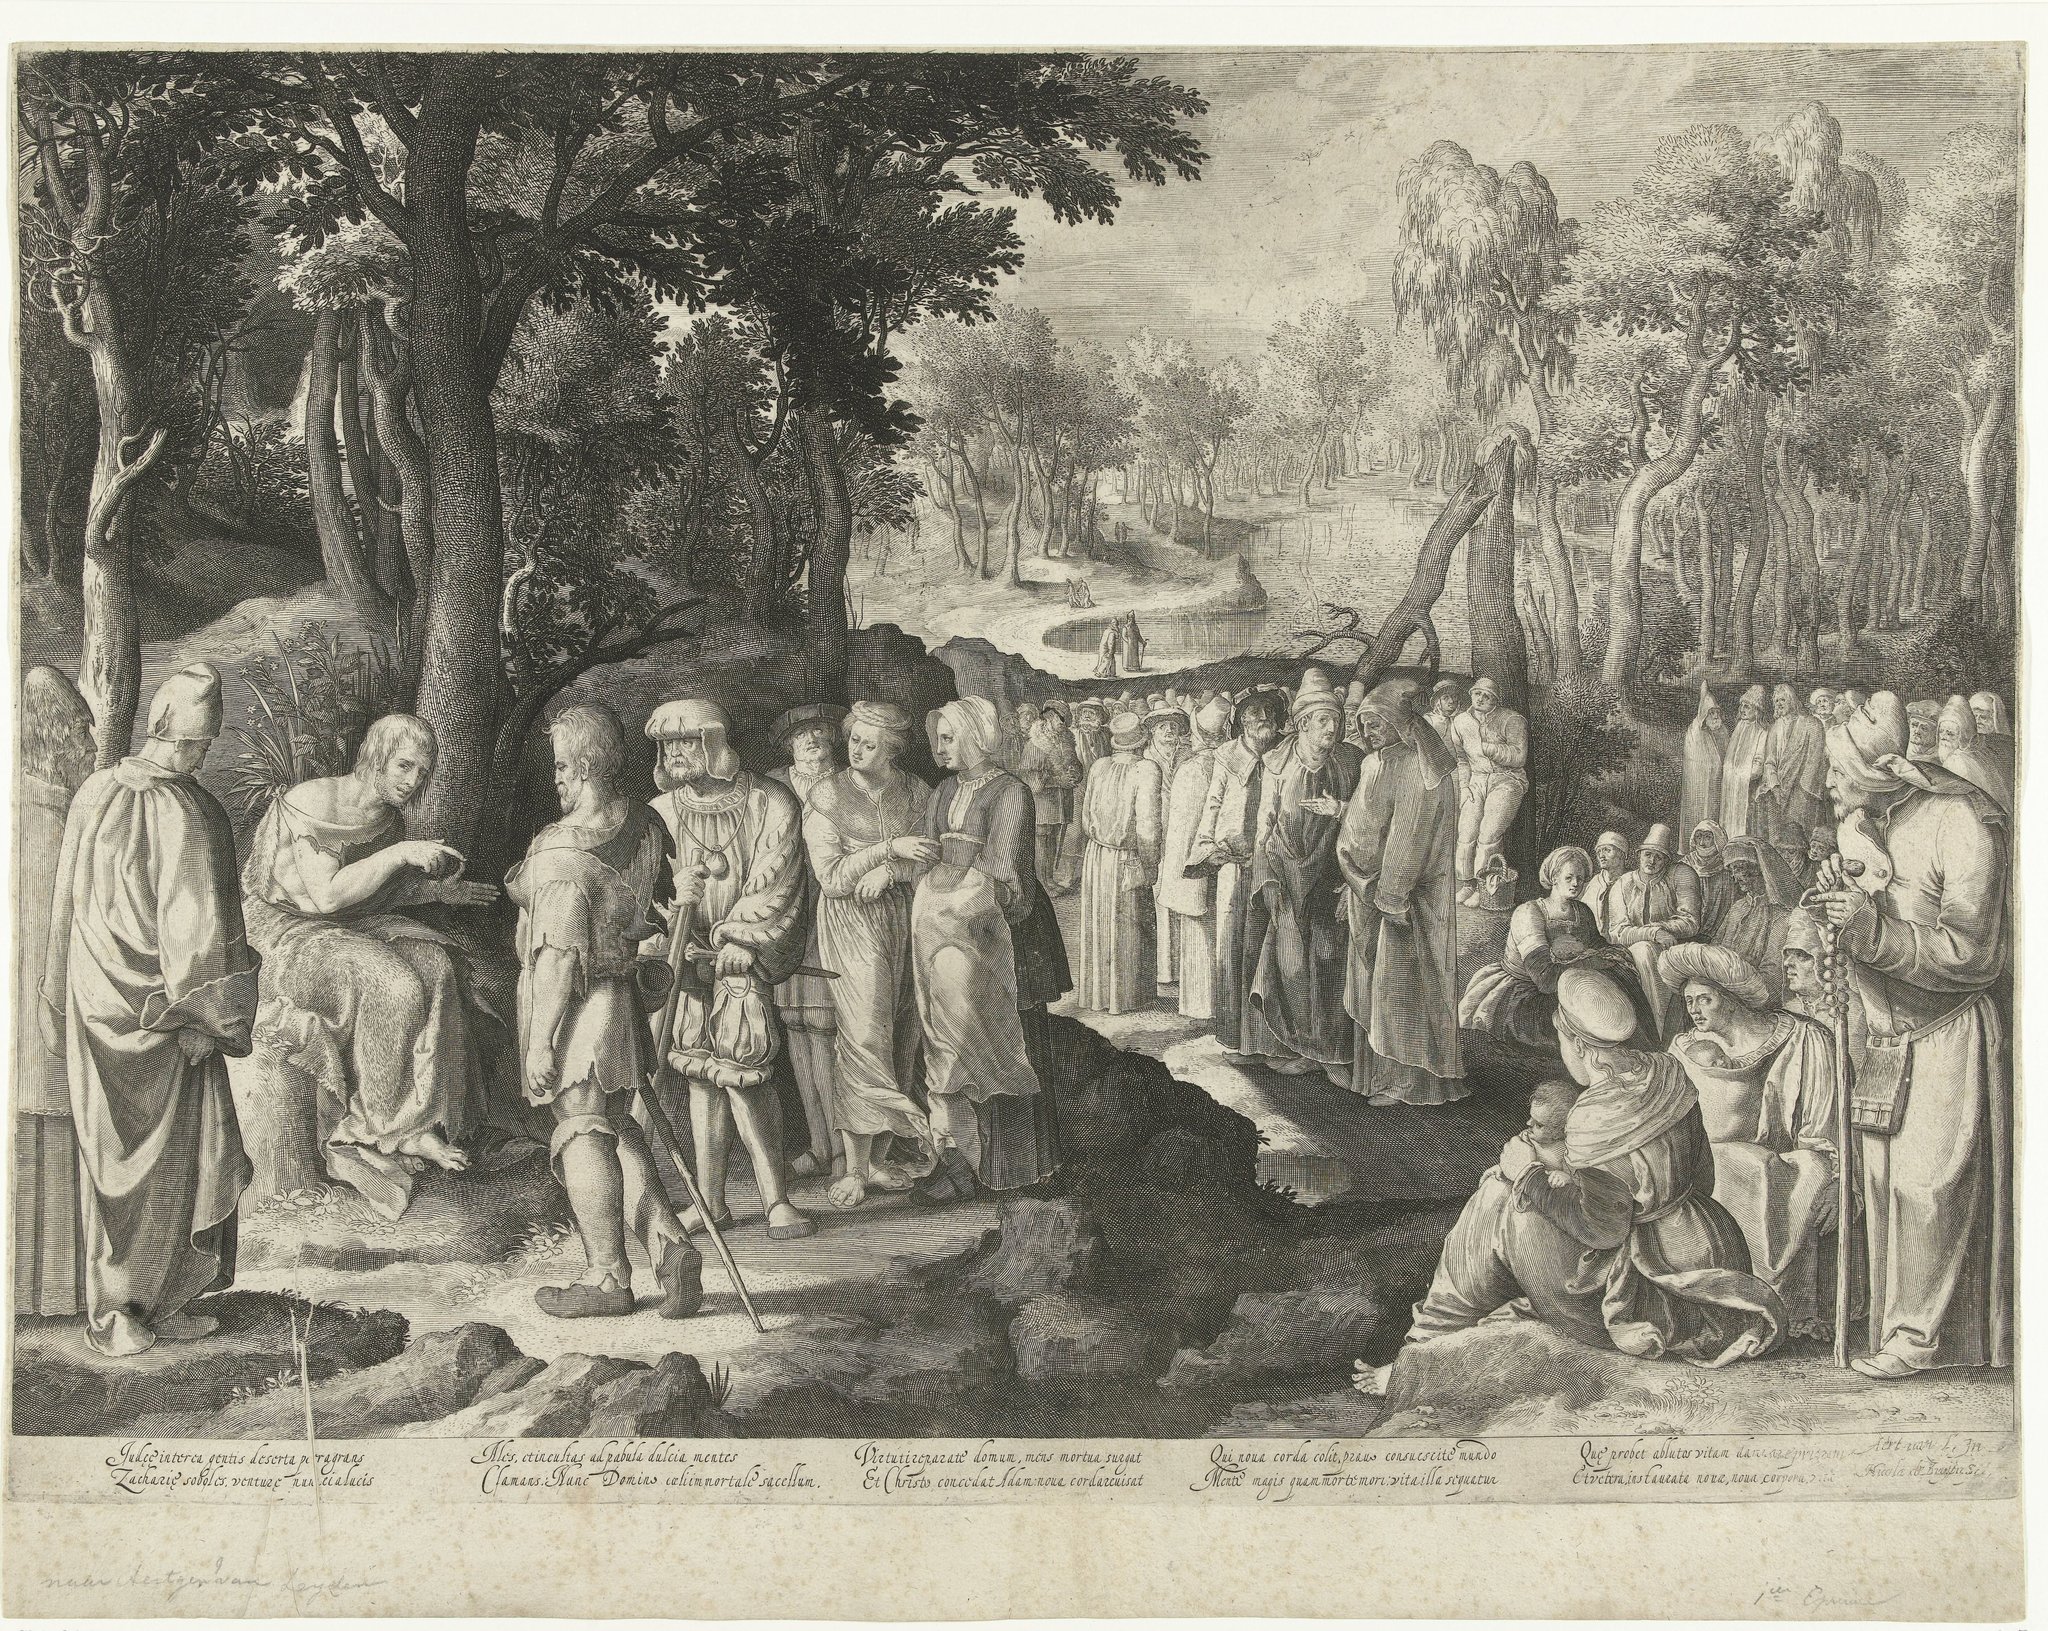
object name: print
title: Johannes de Doper predikt tot de menigte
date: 1581-1656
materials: paper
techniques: engraving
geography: netherlands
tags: john the baptist preaching (perhaps christ among the bystanders)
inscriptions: collector's mark: Lugt 2228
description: Johannes de Doper zit op een rots voor een menigte. Gekleed in zijn kamelenhuid predikt hij voor zijn toehoorders in een boomrijk landschap met een waterpartij op de achtergrond. In de verzamelde groep bevinden zich moeders met kinderen, pelgrims, herders, geleerden en edelmannen. In de marge onder staat een vers in Latijn.